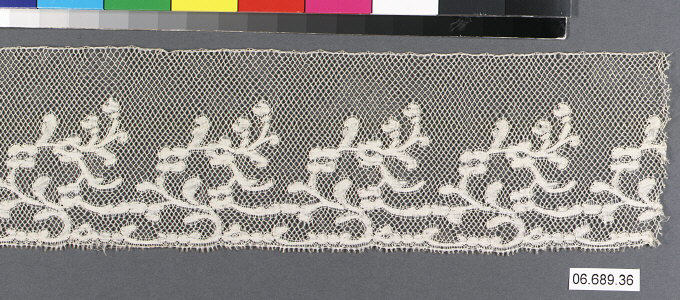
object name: fragment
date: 1801-1900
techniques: lace